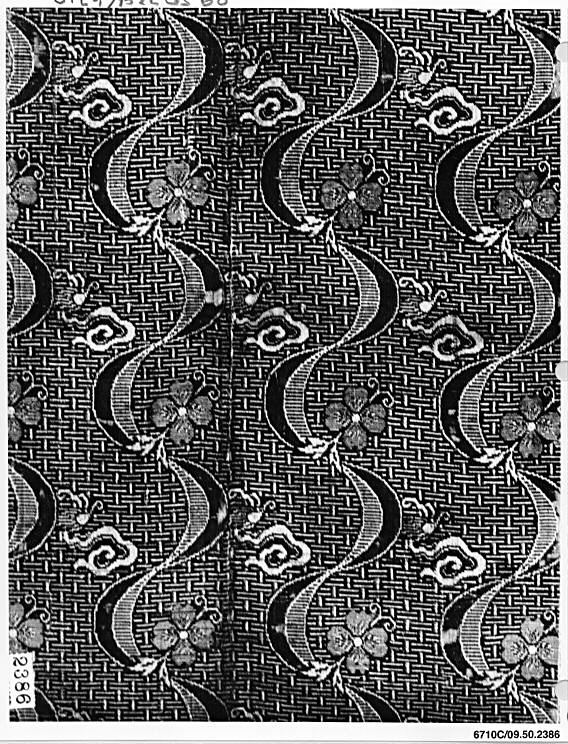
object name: piece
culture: japanese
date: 1801-1900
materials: silk